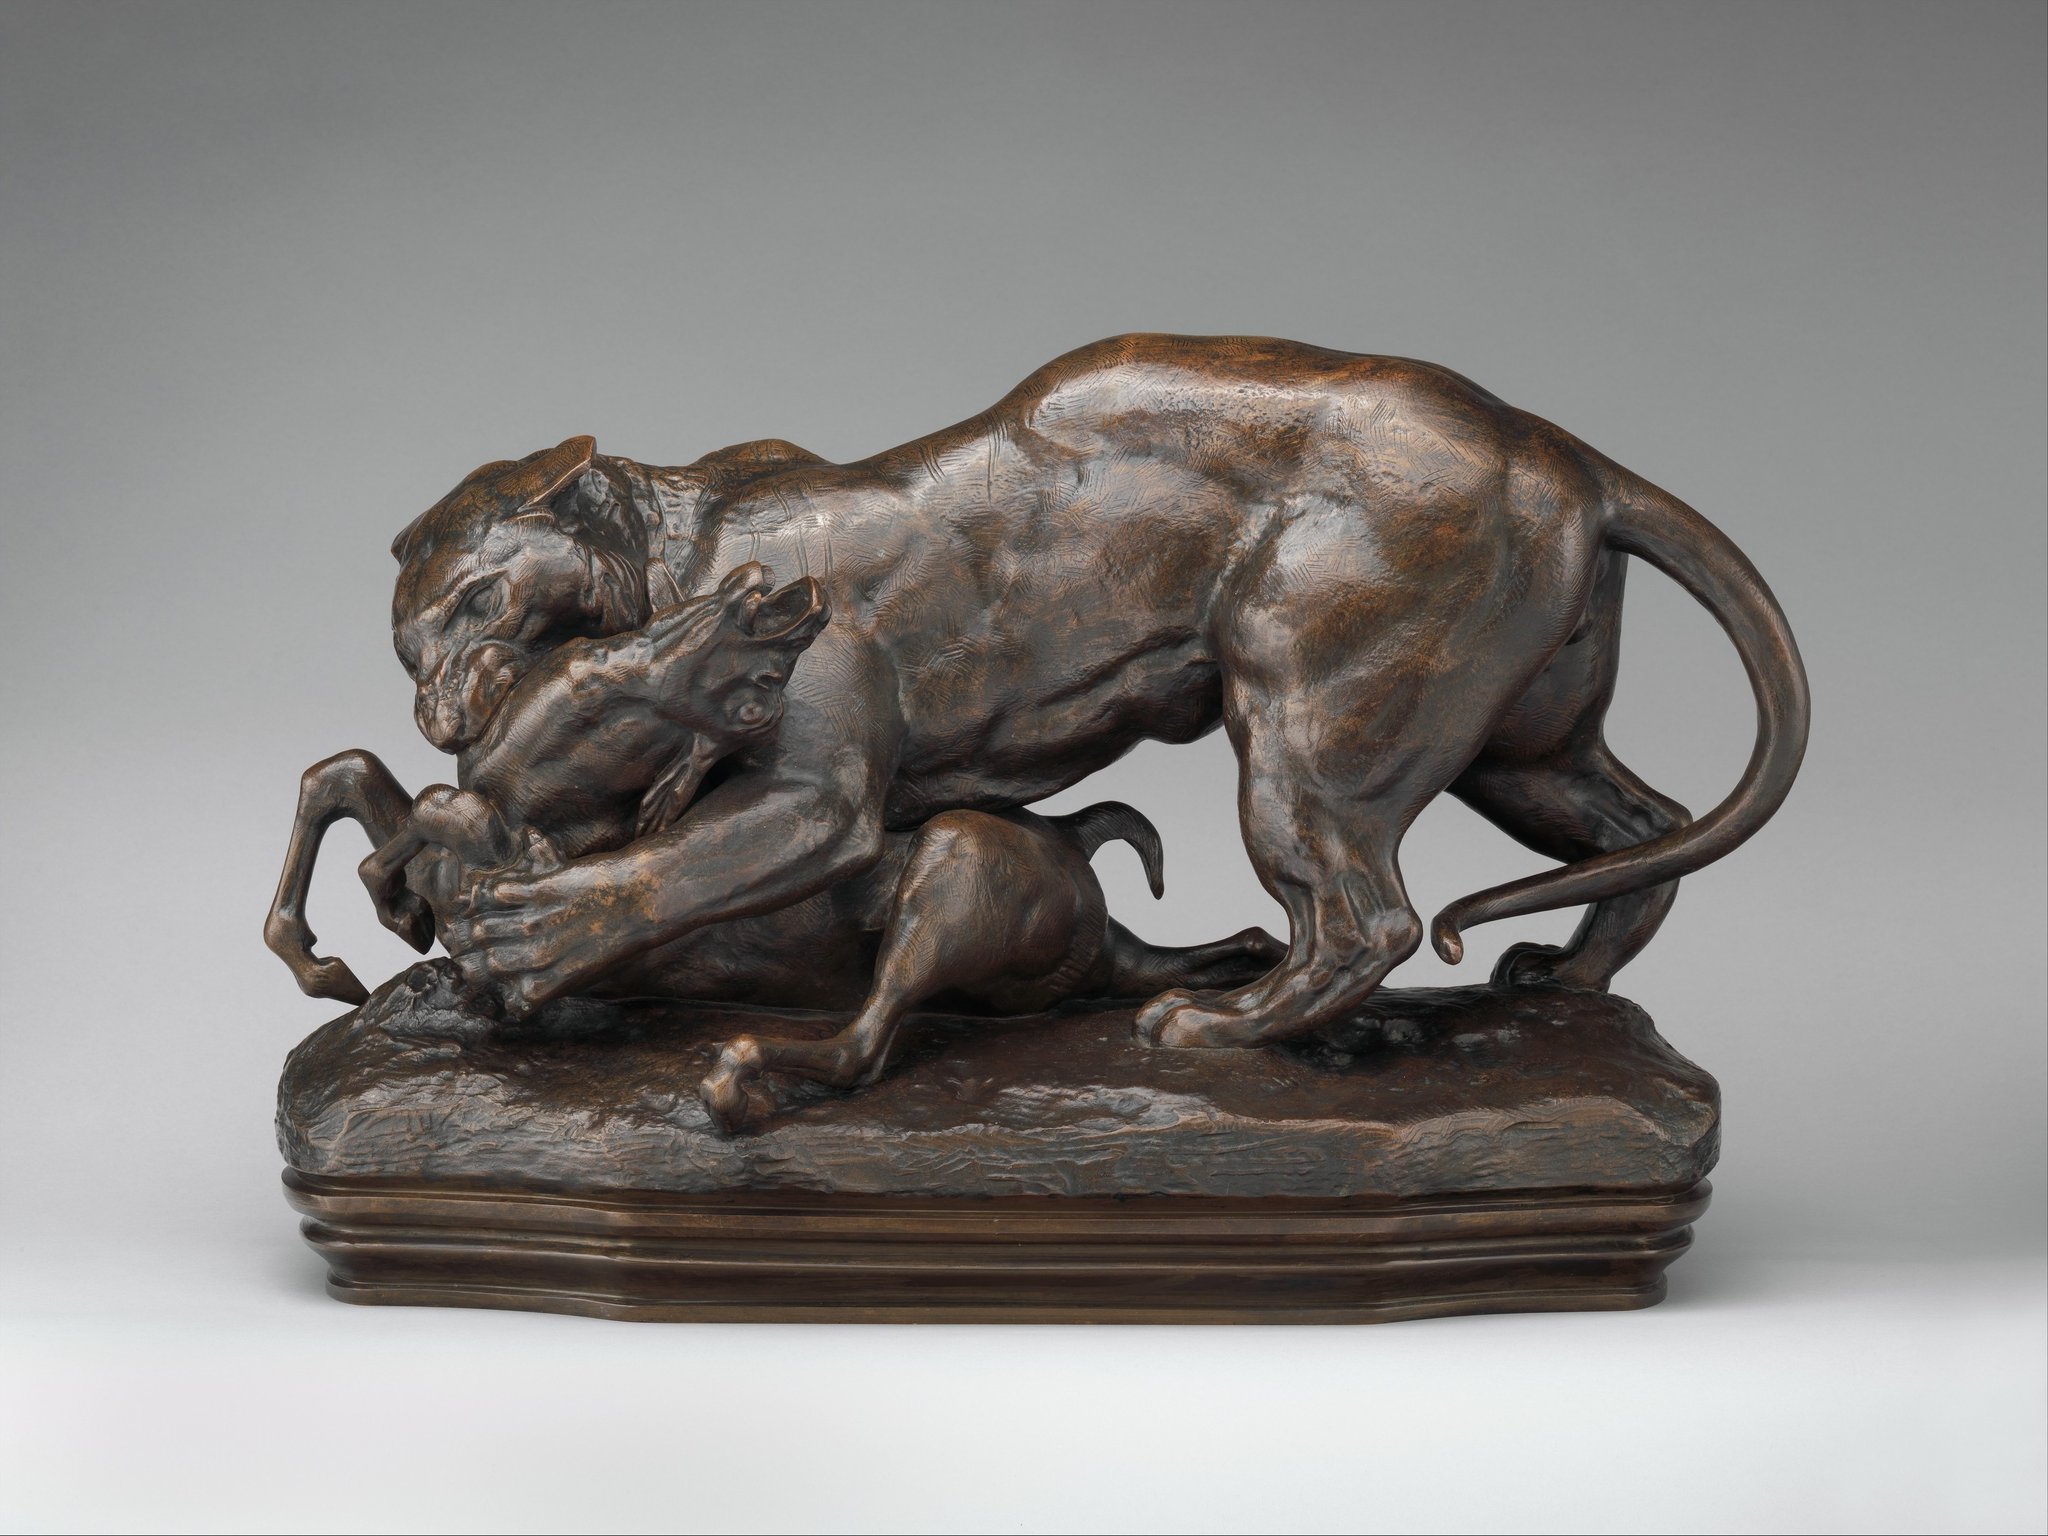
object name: statuette group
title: Tiger Attacking an Antelope (Tigre suprenant une antilope)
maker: antoine-louis barye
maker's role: artist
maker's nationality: french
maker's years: 1795-1875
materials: bronze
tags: hunting,deer,tigers